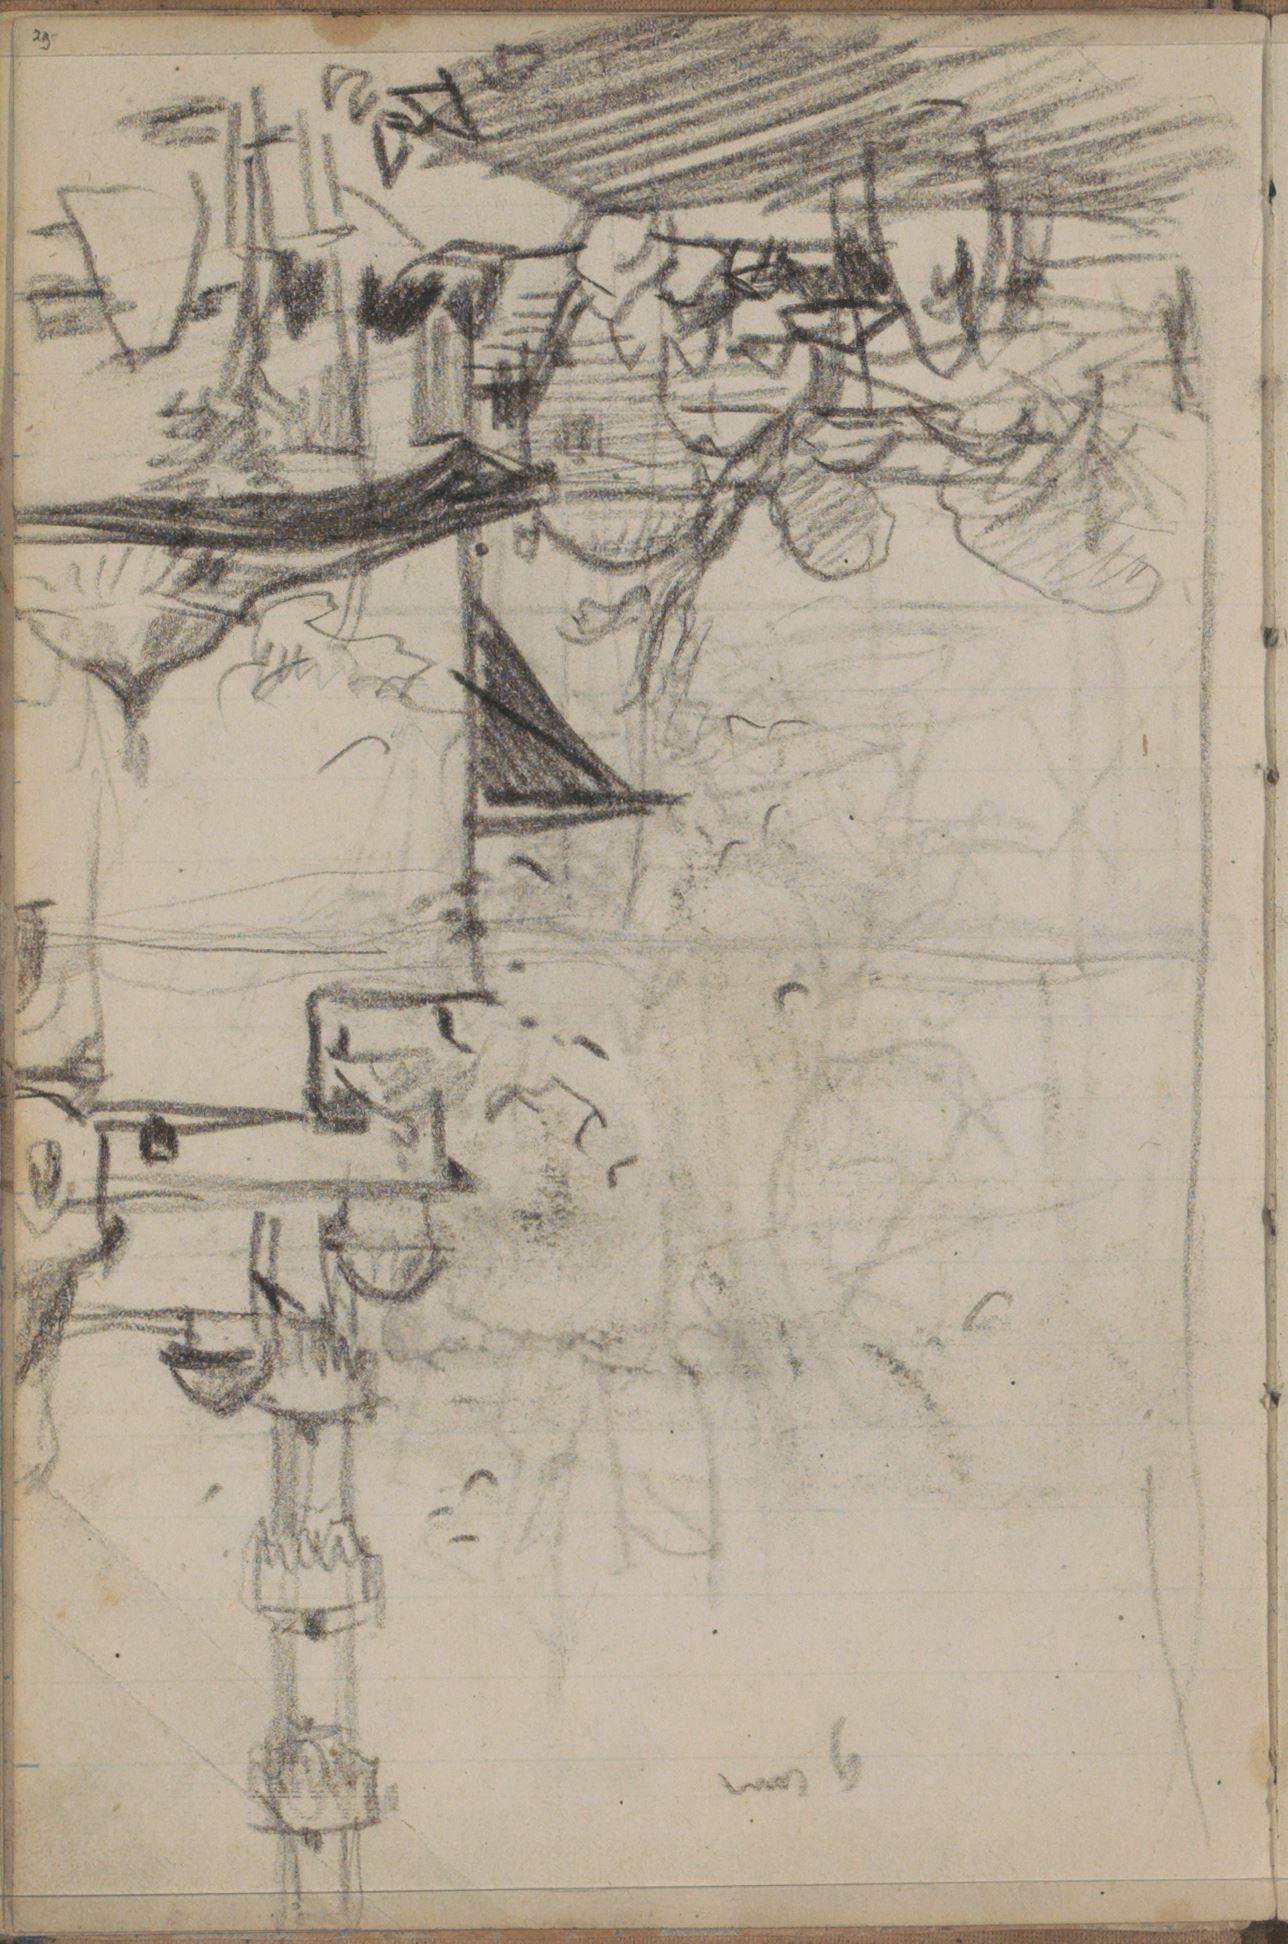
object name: sketchbook leaf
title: Zijaanzicht van een moskee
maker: marius bauer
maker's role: draughtsman, print maker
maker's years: 1867-1932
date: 1888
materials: chalk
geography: istanbul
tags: temple, shrine ~ islam, mohammedanism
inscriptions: kleurnotitie, handgeschreven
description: Pagina 29 uit een schetsboek met 58 bladen.